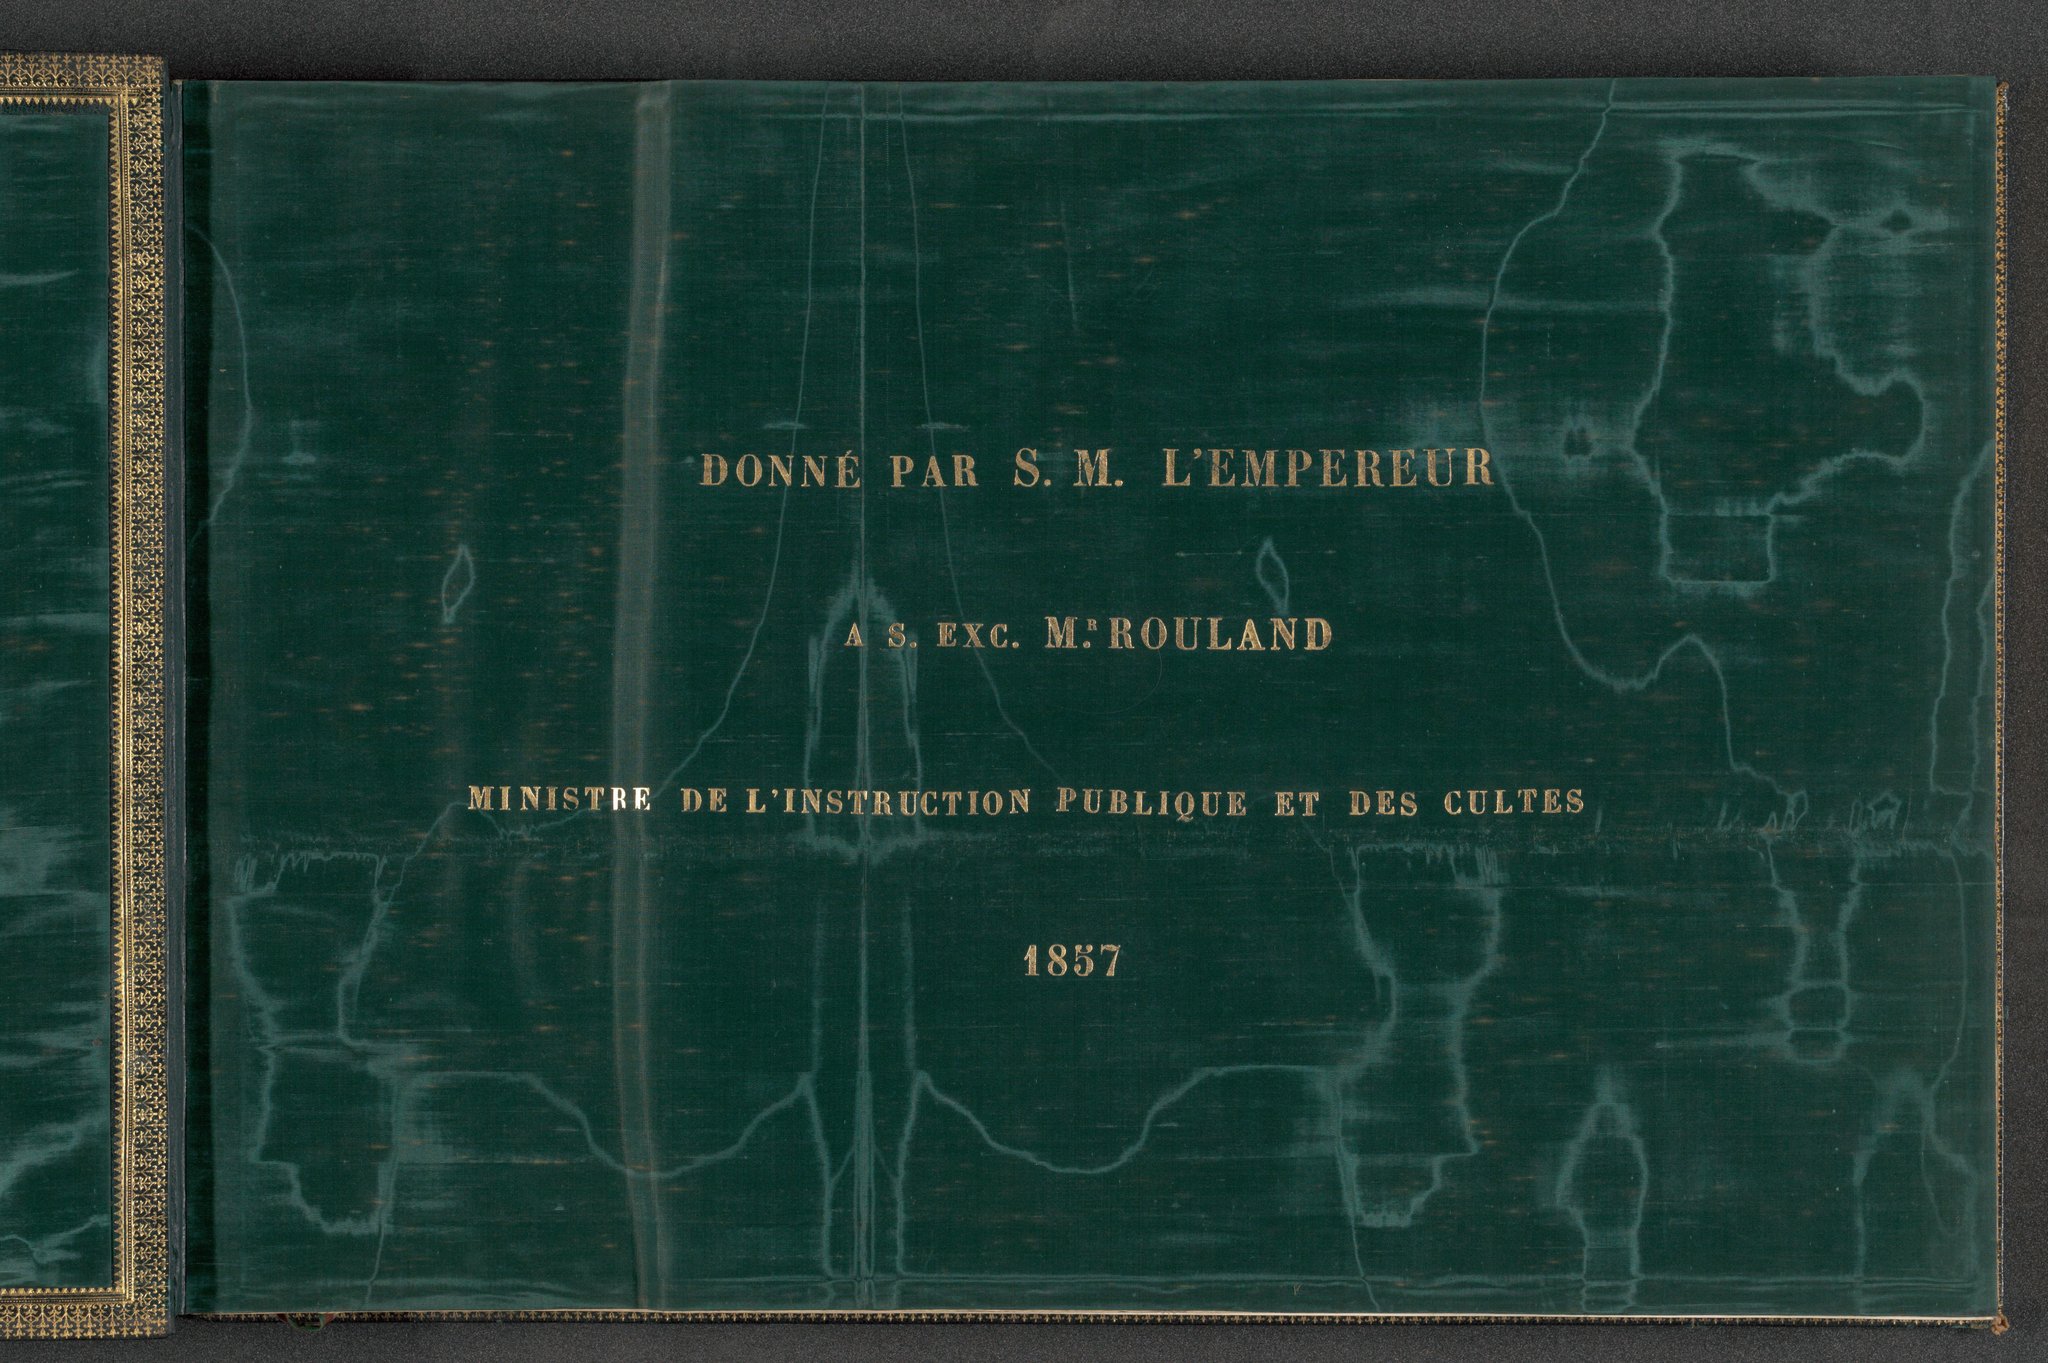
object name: album leaf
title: Namen van de schenker (keizer Napoleon III) en de ontvanger (minister Rouland) van het fotoalbum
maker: Anonymous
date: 1857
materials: paper, textile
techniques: printing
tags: permanent exhibition, museum, paris, tuileries palace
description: Onderdeel van Réunion des Tuileries au Louvre 1852-1857, album 2.